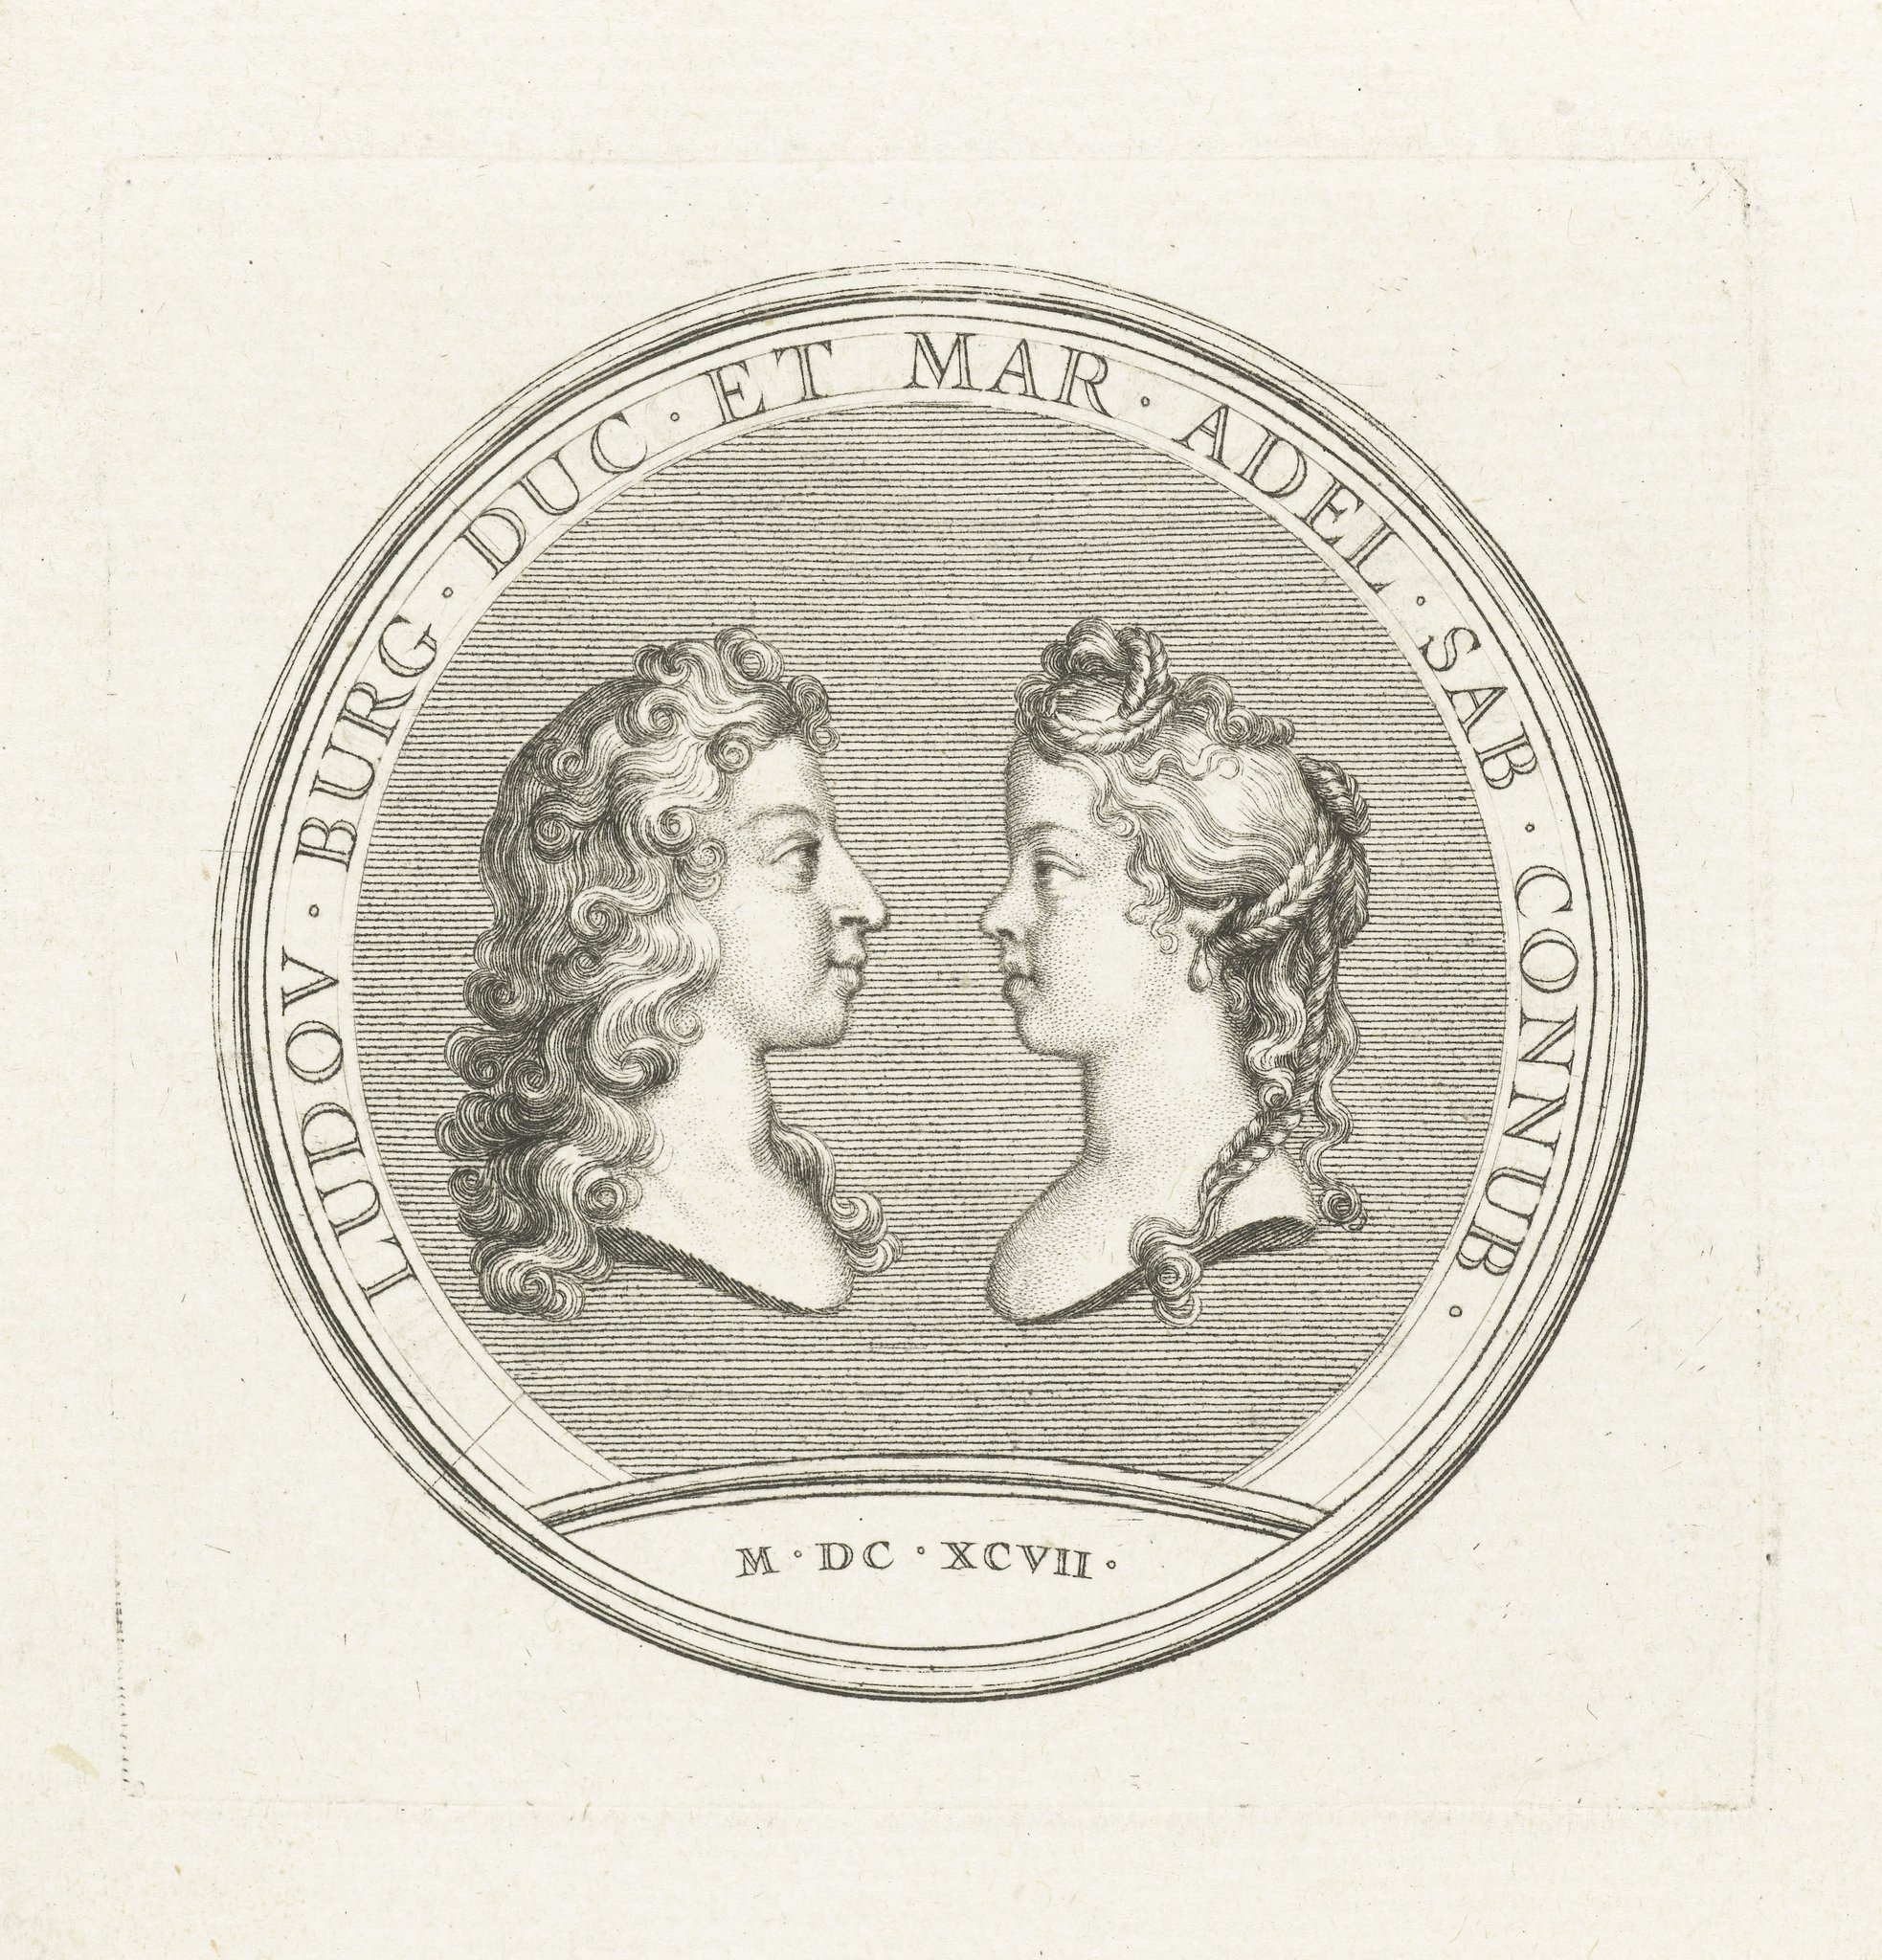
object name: print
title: Penning met bustes van de hertog en hertogin van Bourgondië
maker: gerard edelinck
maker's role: print maker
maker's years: 1640-1707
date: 1702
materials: paper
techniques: engraving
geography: paris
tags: lodewijk van frankrijk (hertog van bourgondië)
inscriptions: collector's mark: Lugt 240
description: Achterkant van een penning met bustes en profil van Lodewijk, hertog van Bourgondië en Maria Adelheid van Savoye, elkaar aankijkend. De penning is gedateerd 1697: het jaar van hun huwelijk.